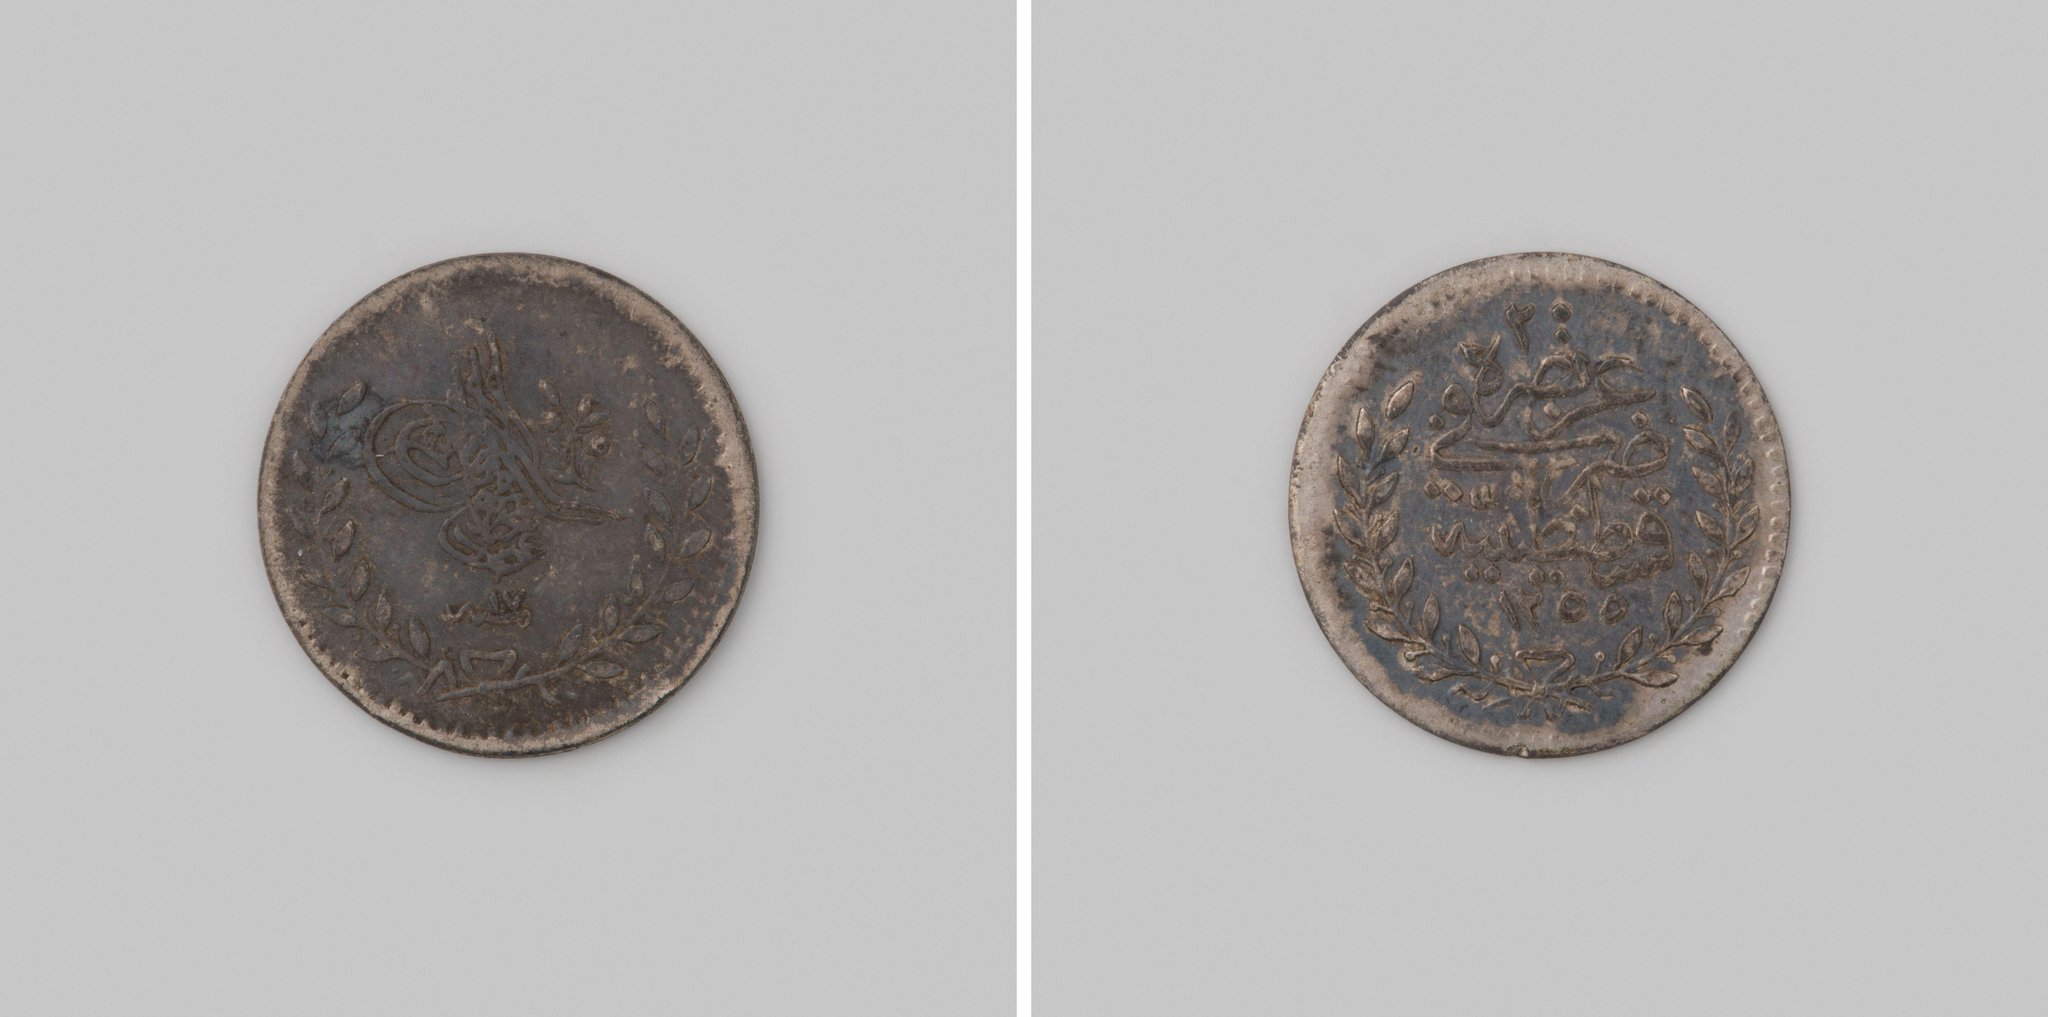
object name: coin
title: 20 para uit Turkije van sultan Abdul Medjid, regeringsjaar 6 [=1844]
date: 1844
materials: silver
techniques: striking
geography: constantinople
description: Zilveren munt. Voorzijde: binnen krans van bloemen tughra met rechts daarvan takje met bladeren. Onder tughra aanduiding regeringsjaar: 6. Keerzijde: binnen krans van bloemen drieregelig opschrift in Arabische letters met muntplaats-aanduiding: Constantinopel. Onder muntplaats-aanduiding jaar van aantreden: 1255 [=1839].